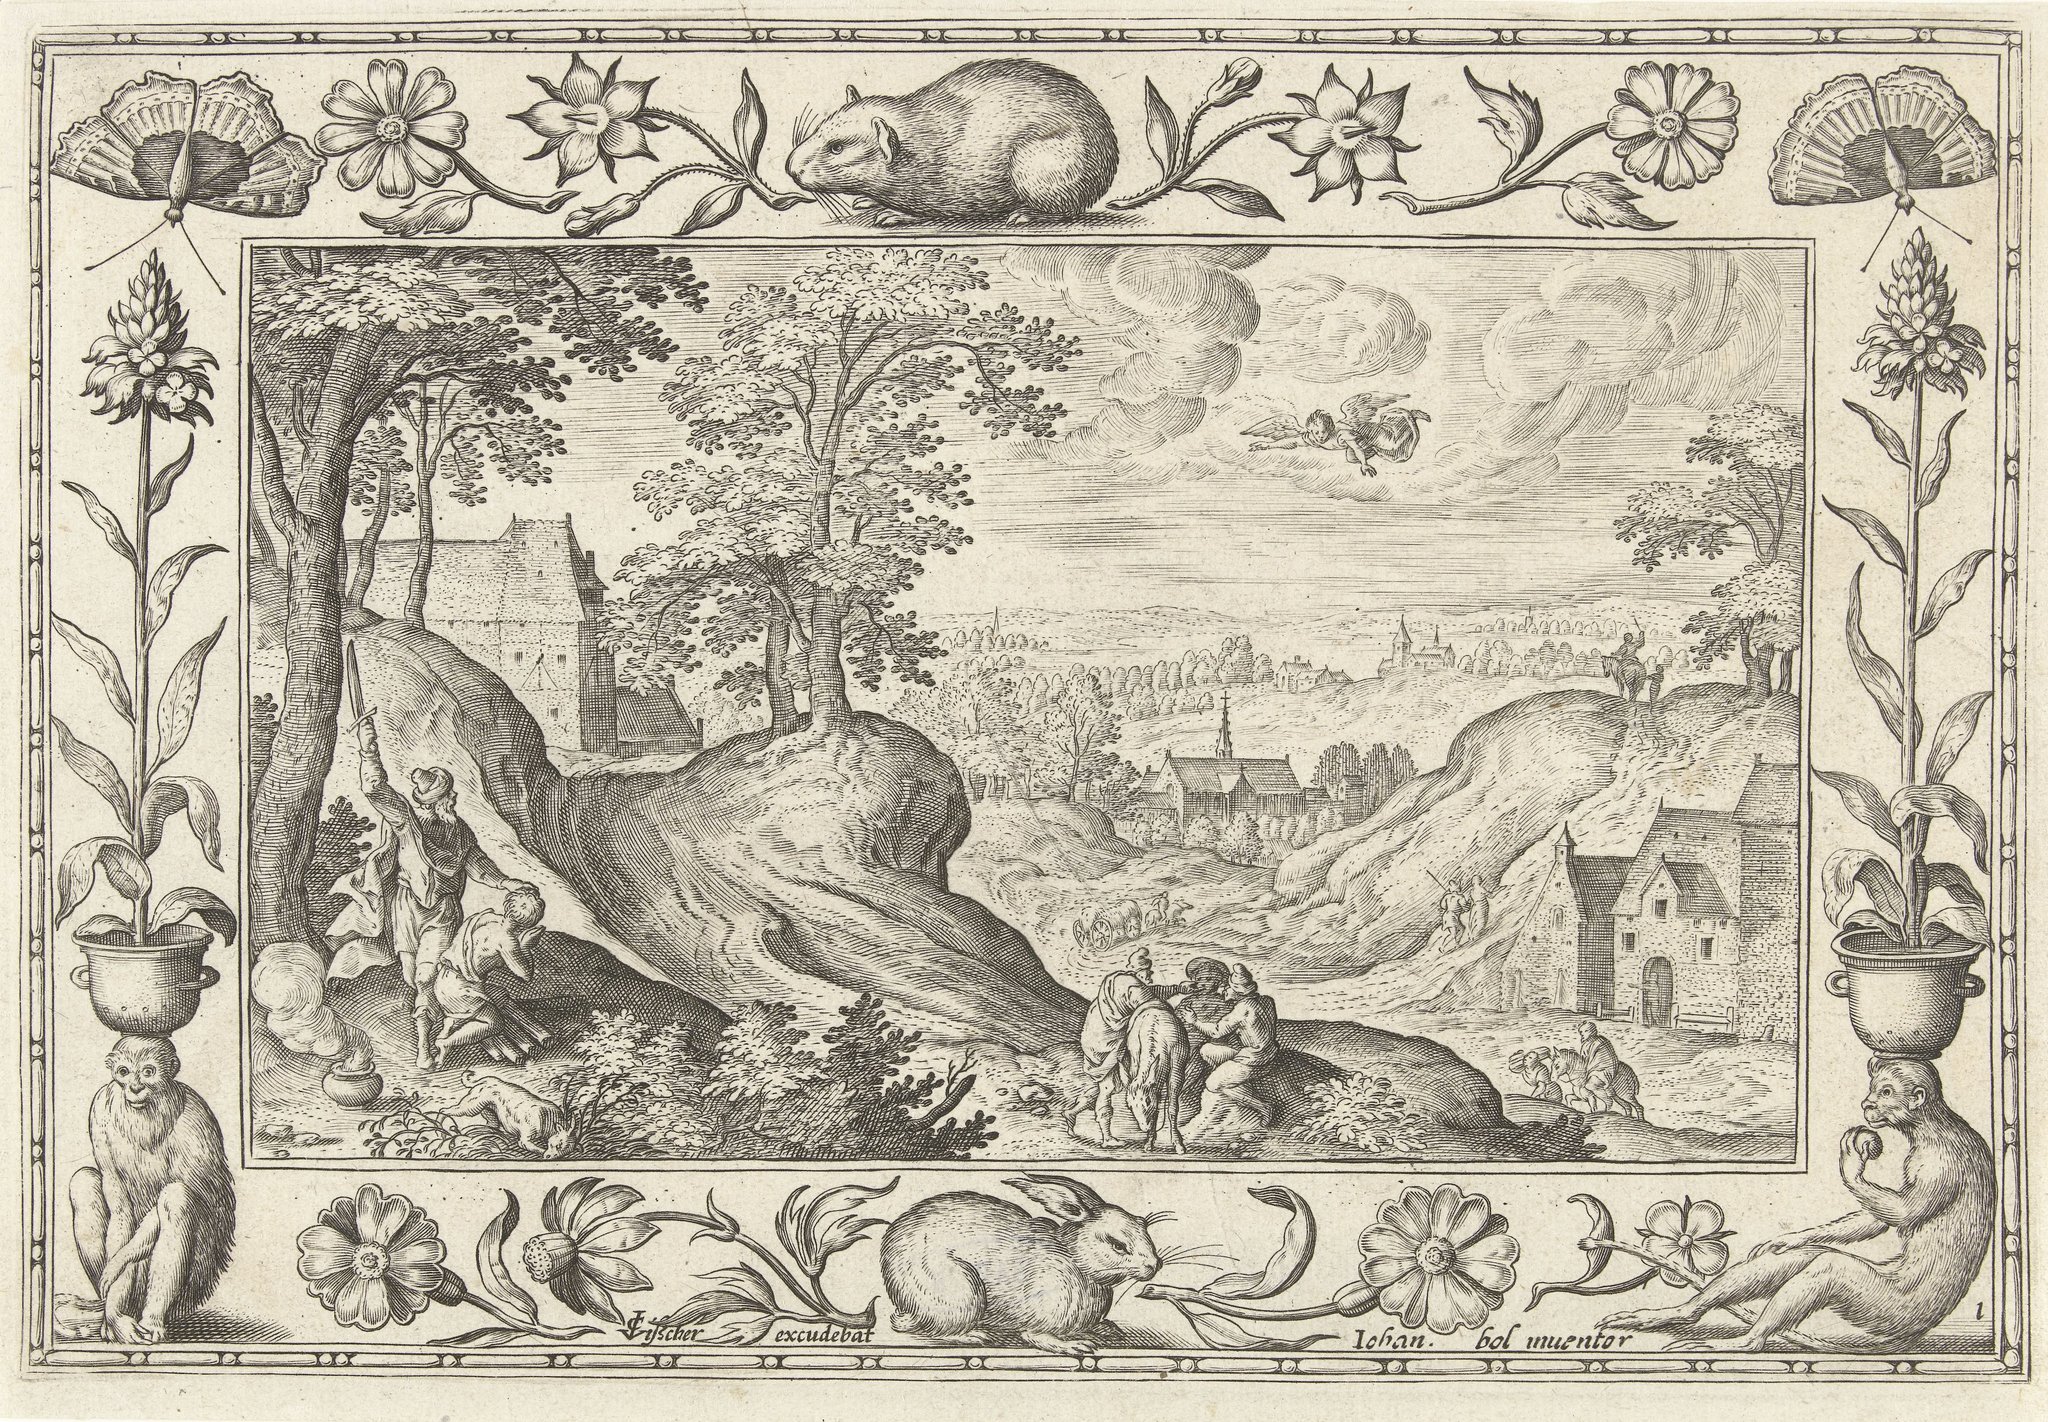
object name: print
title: Abraham offert Isaak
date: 1582-1652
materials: paper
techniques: engraving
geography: antwerp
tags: dale, valley, a ram caught in a thicket is sacrificed instead of isaac, flowers (+ ornamental variants of plants), rodents: rabbit (+ ornamental variants of animals), rodents: rat (+ ornamental variants of animals), monkeys, apes (+ ornamental variants of animals)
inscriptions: collector's mark: Lugt 2228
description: Heuvelachtig landschap met links op de voorgrond Abraham die zijn zoon Isaac wil offeren. Een engel in de lucht verschijnt en verhindert het offer. De prent heeft een ornamentlijst met bloemen en dieren. Hij maakt deel uit van een vierentwintigdelige serie van landschappen met Bijbelse, mythologische scènes en jachttaferelen.